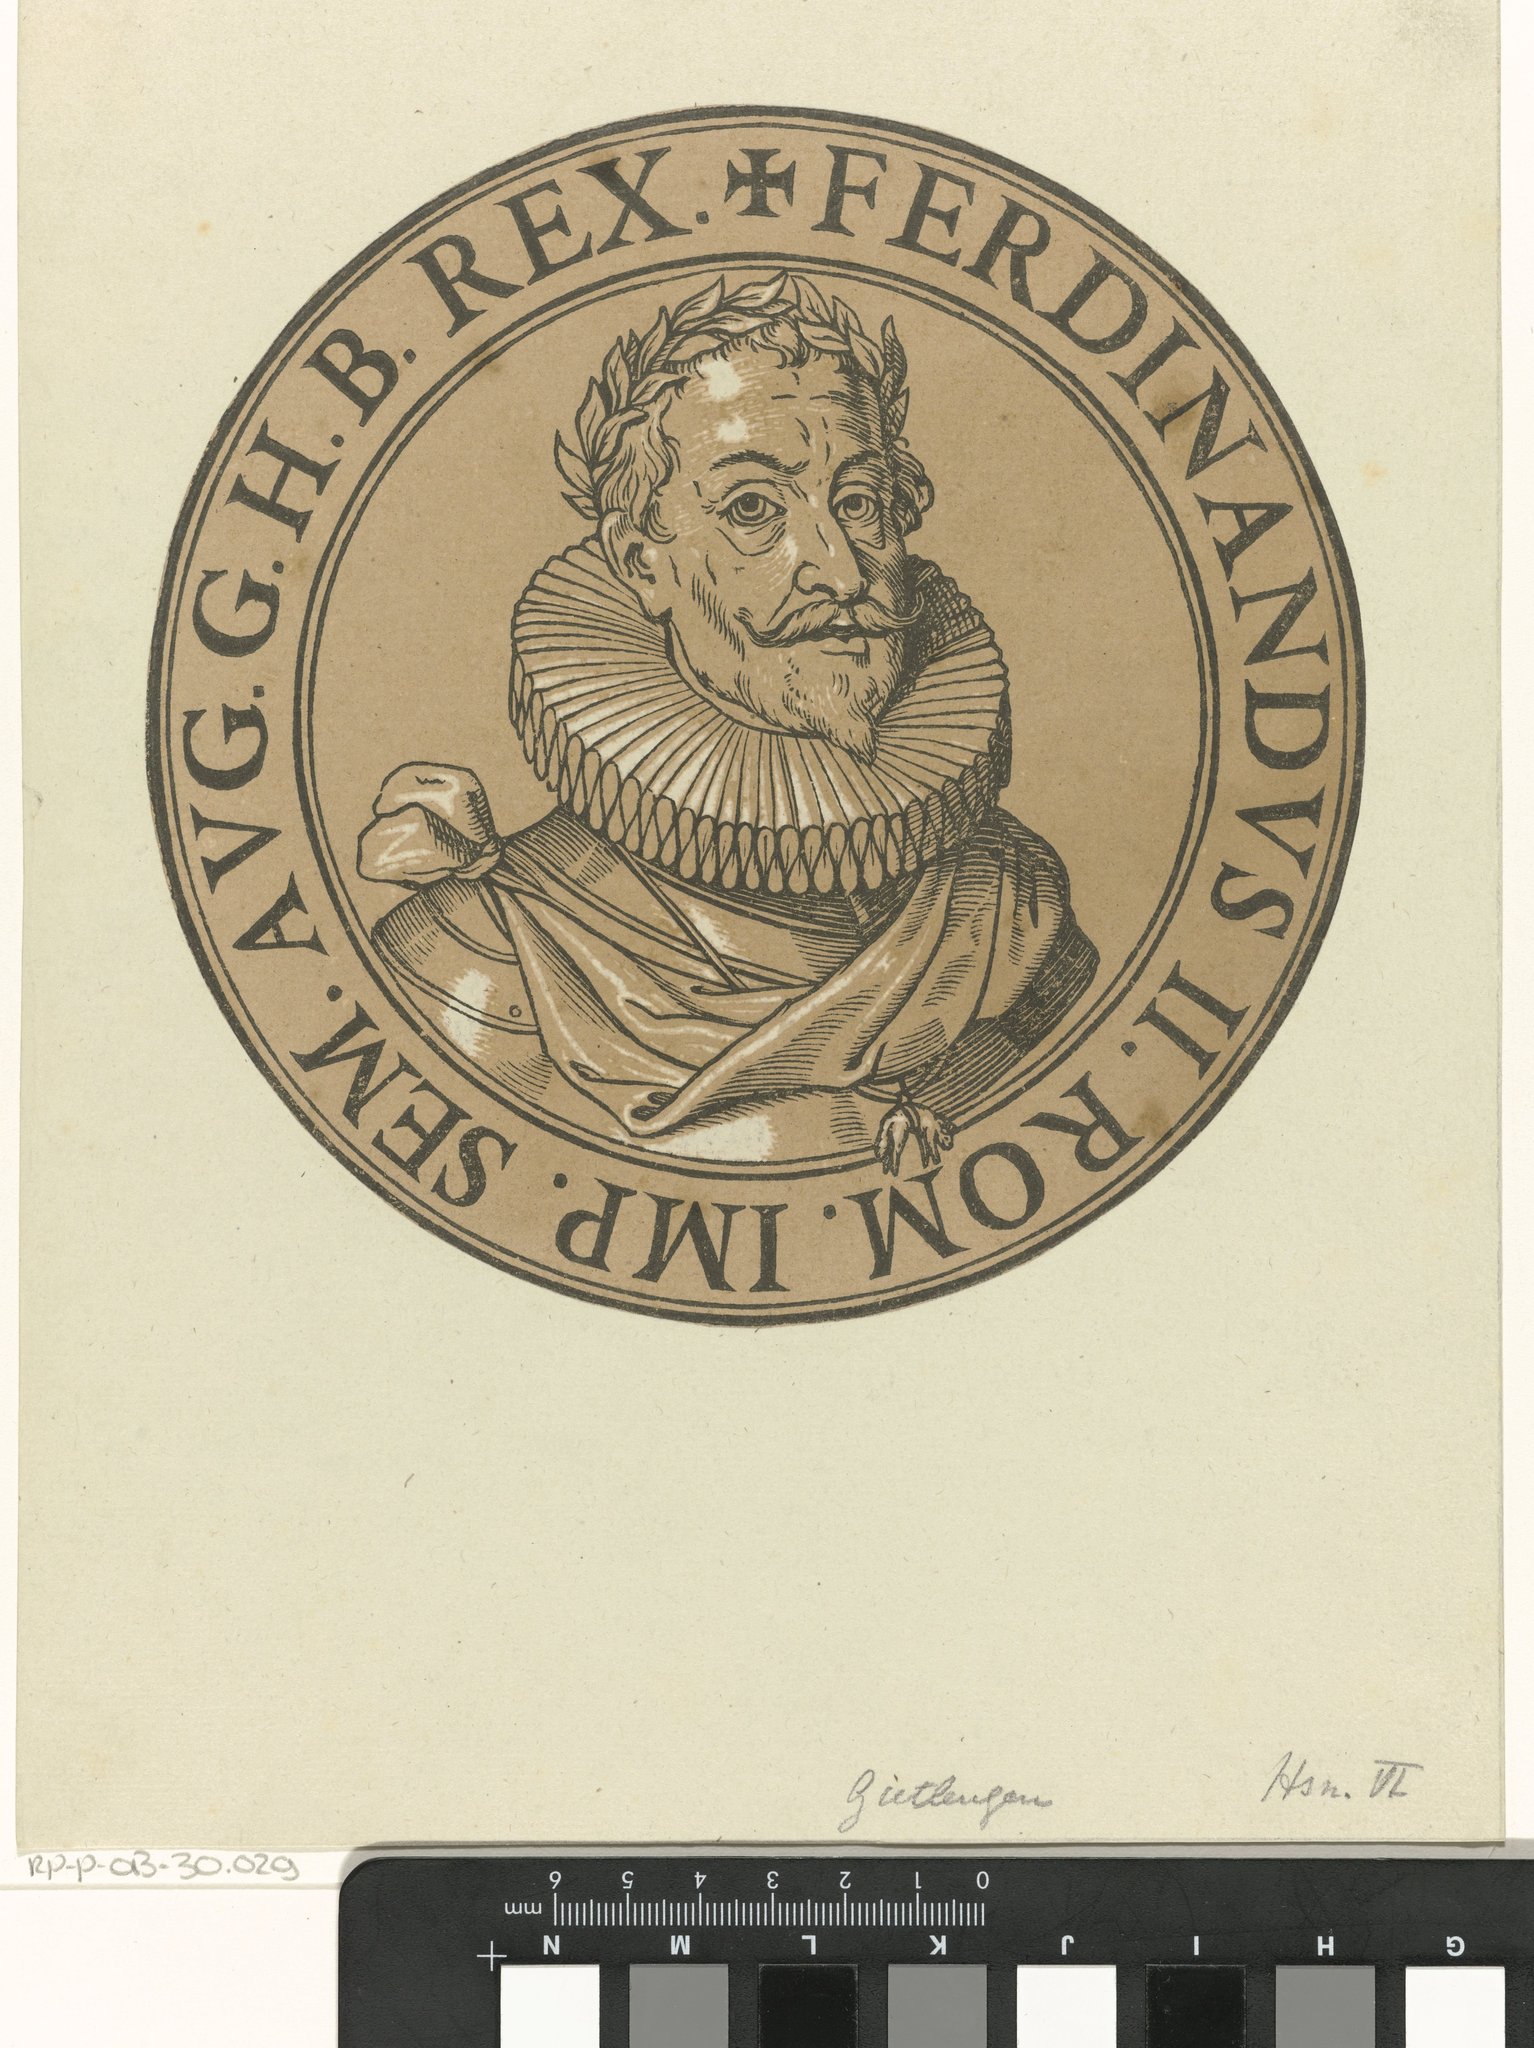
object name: print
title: Medaillon met een portret van keizer Ferdinandus II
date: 1645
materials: paper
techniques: woodcut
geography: antwerp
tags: vienna, ferdinand ii (duits keizer), knighthood order of the golden fleece, emperor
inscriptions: collector's mark: Lugt 240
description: Prent ook gebruikt voor: Icones Imperatorum Romanorum, Antwerpen: Ex officina Plantiniana Balthasaris Moreti, 1645, p. 389.